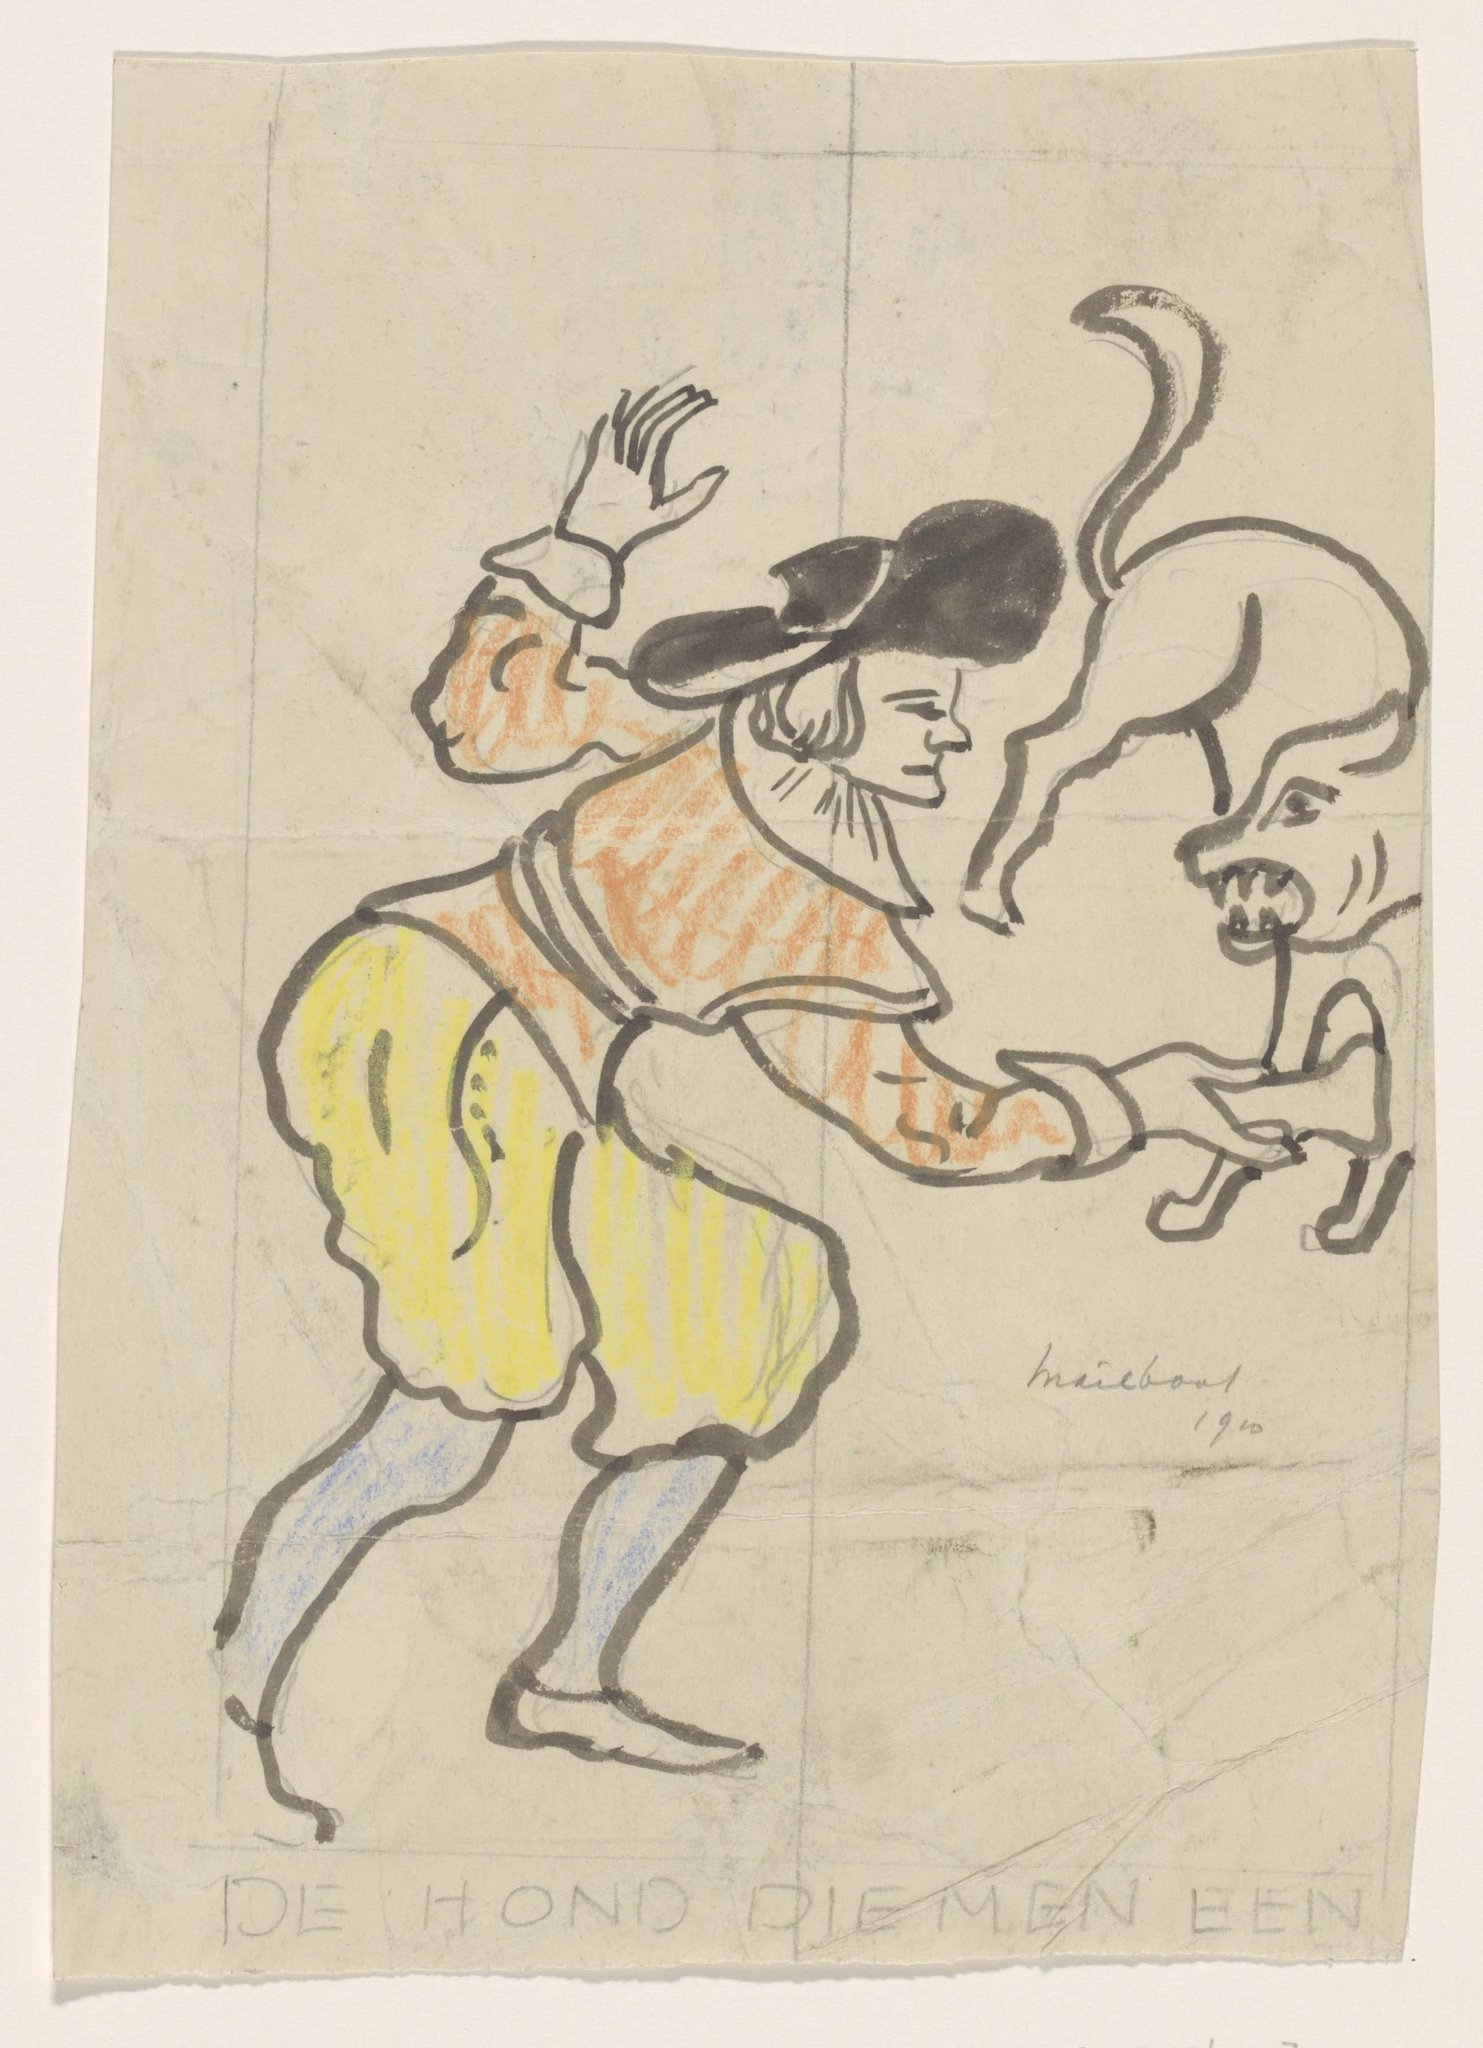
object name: drawing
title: Ontwerp voor decoratie met man en hond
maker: carel adolph lion cachet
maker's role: draughtsman, print maker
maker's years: 1864-1945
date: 1874-1945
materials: chalk, ink, paper, pencil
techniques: pen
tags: dog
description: Ontwerp voor decoratie van de kinderkamer van de mailboot: man met hond `De hond die men een ...'.